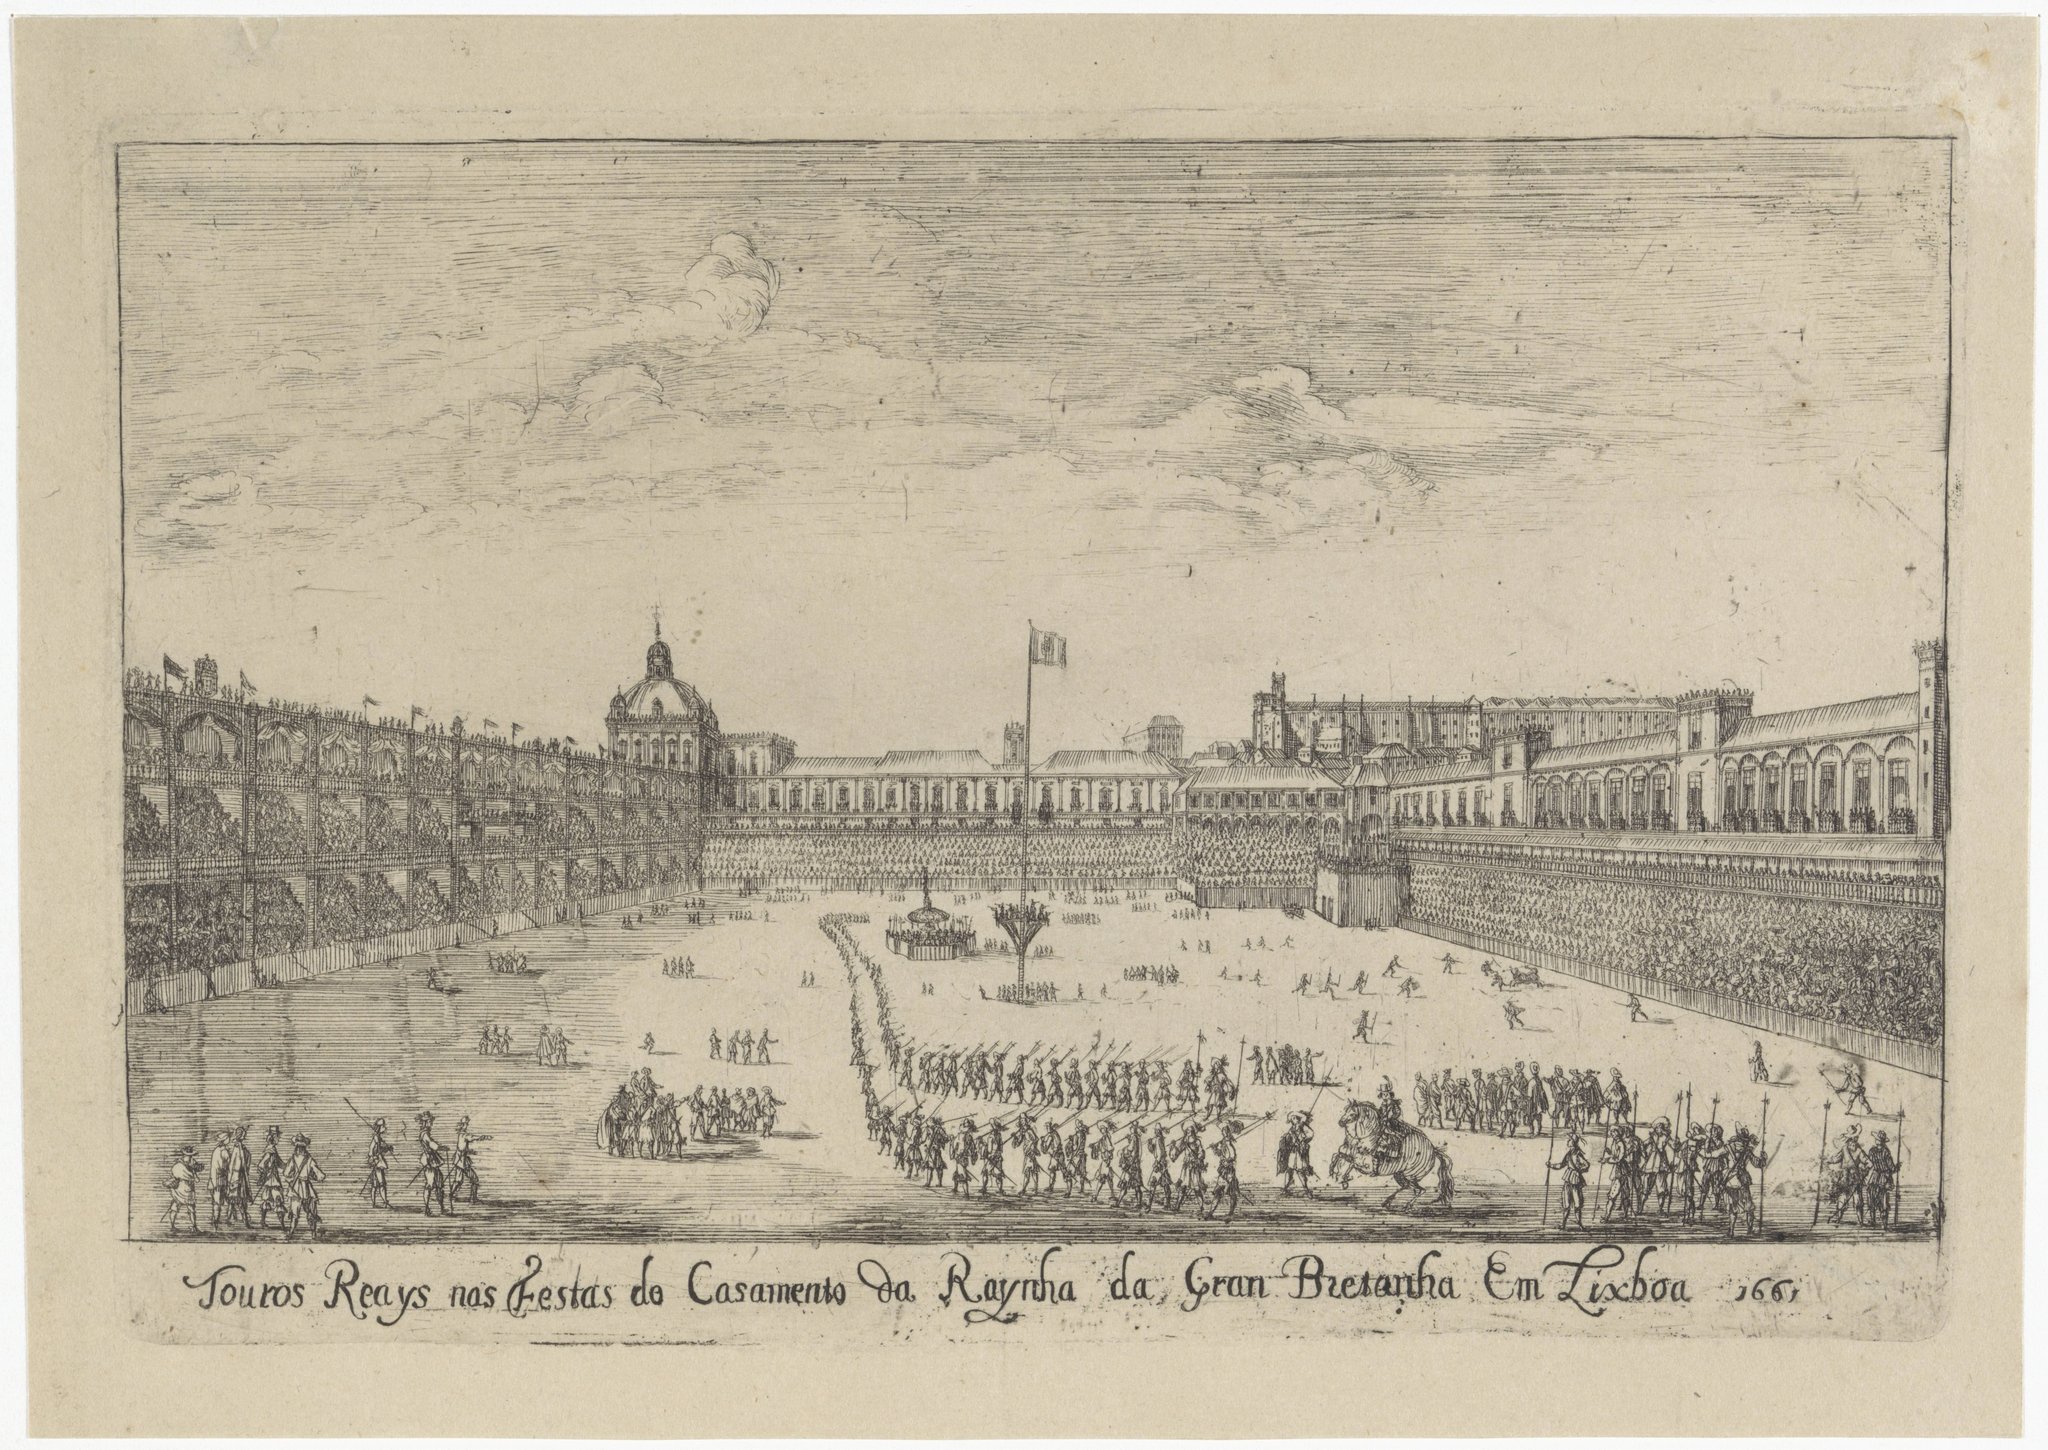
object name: print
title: Gezichten op Lissabon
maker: dirk stoop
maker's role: draughtsman, painter, print maker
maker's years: 1615-1686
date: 1662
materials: paper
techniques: etching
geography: lisbon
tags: catharina van bragança, bullfight, public festivities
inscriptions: collector's mark: Lugt 2228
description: Rond een groot plein staan tribunes opgesteld met toeschouwers, die de feestelijkheden gadeslaan. Soldaten trekken in een stoet voorbij en rechts vindt een stierengevecht plaats. Op de achtergrond het koninklijk paleis te Lissabon. Het feest vond plaats in 1661 ter gelegenheid van het huwelijk van prinses Catharina van Braganza met koning Karel II van Engeland.